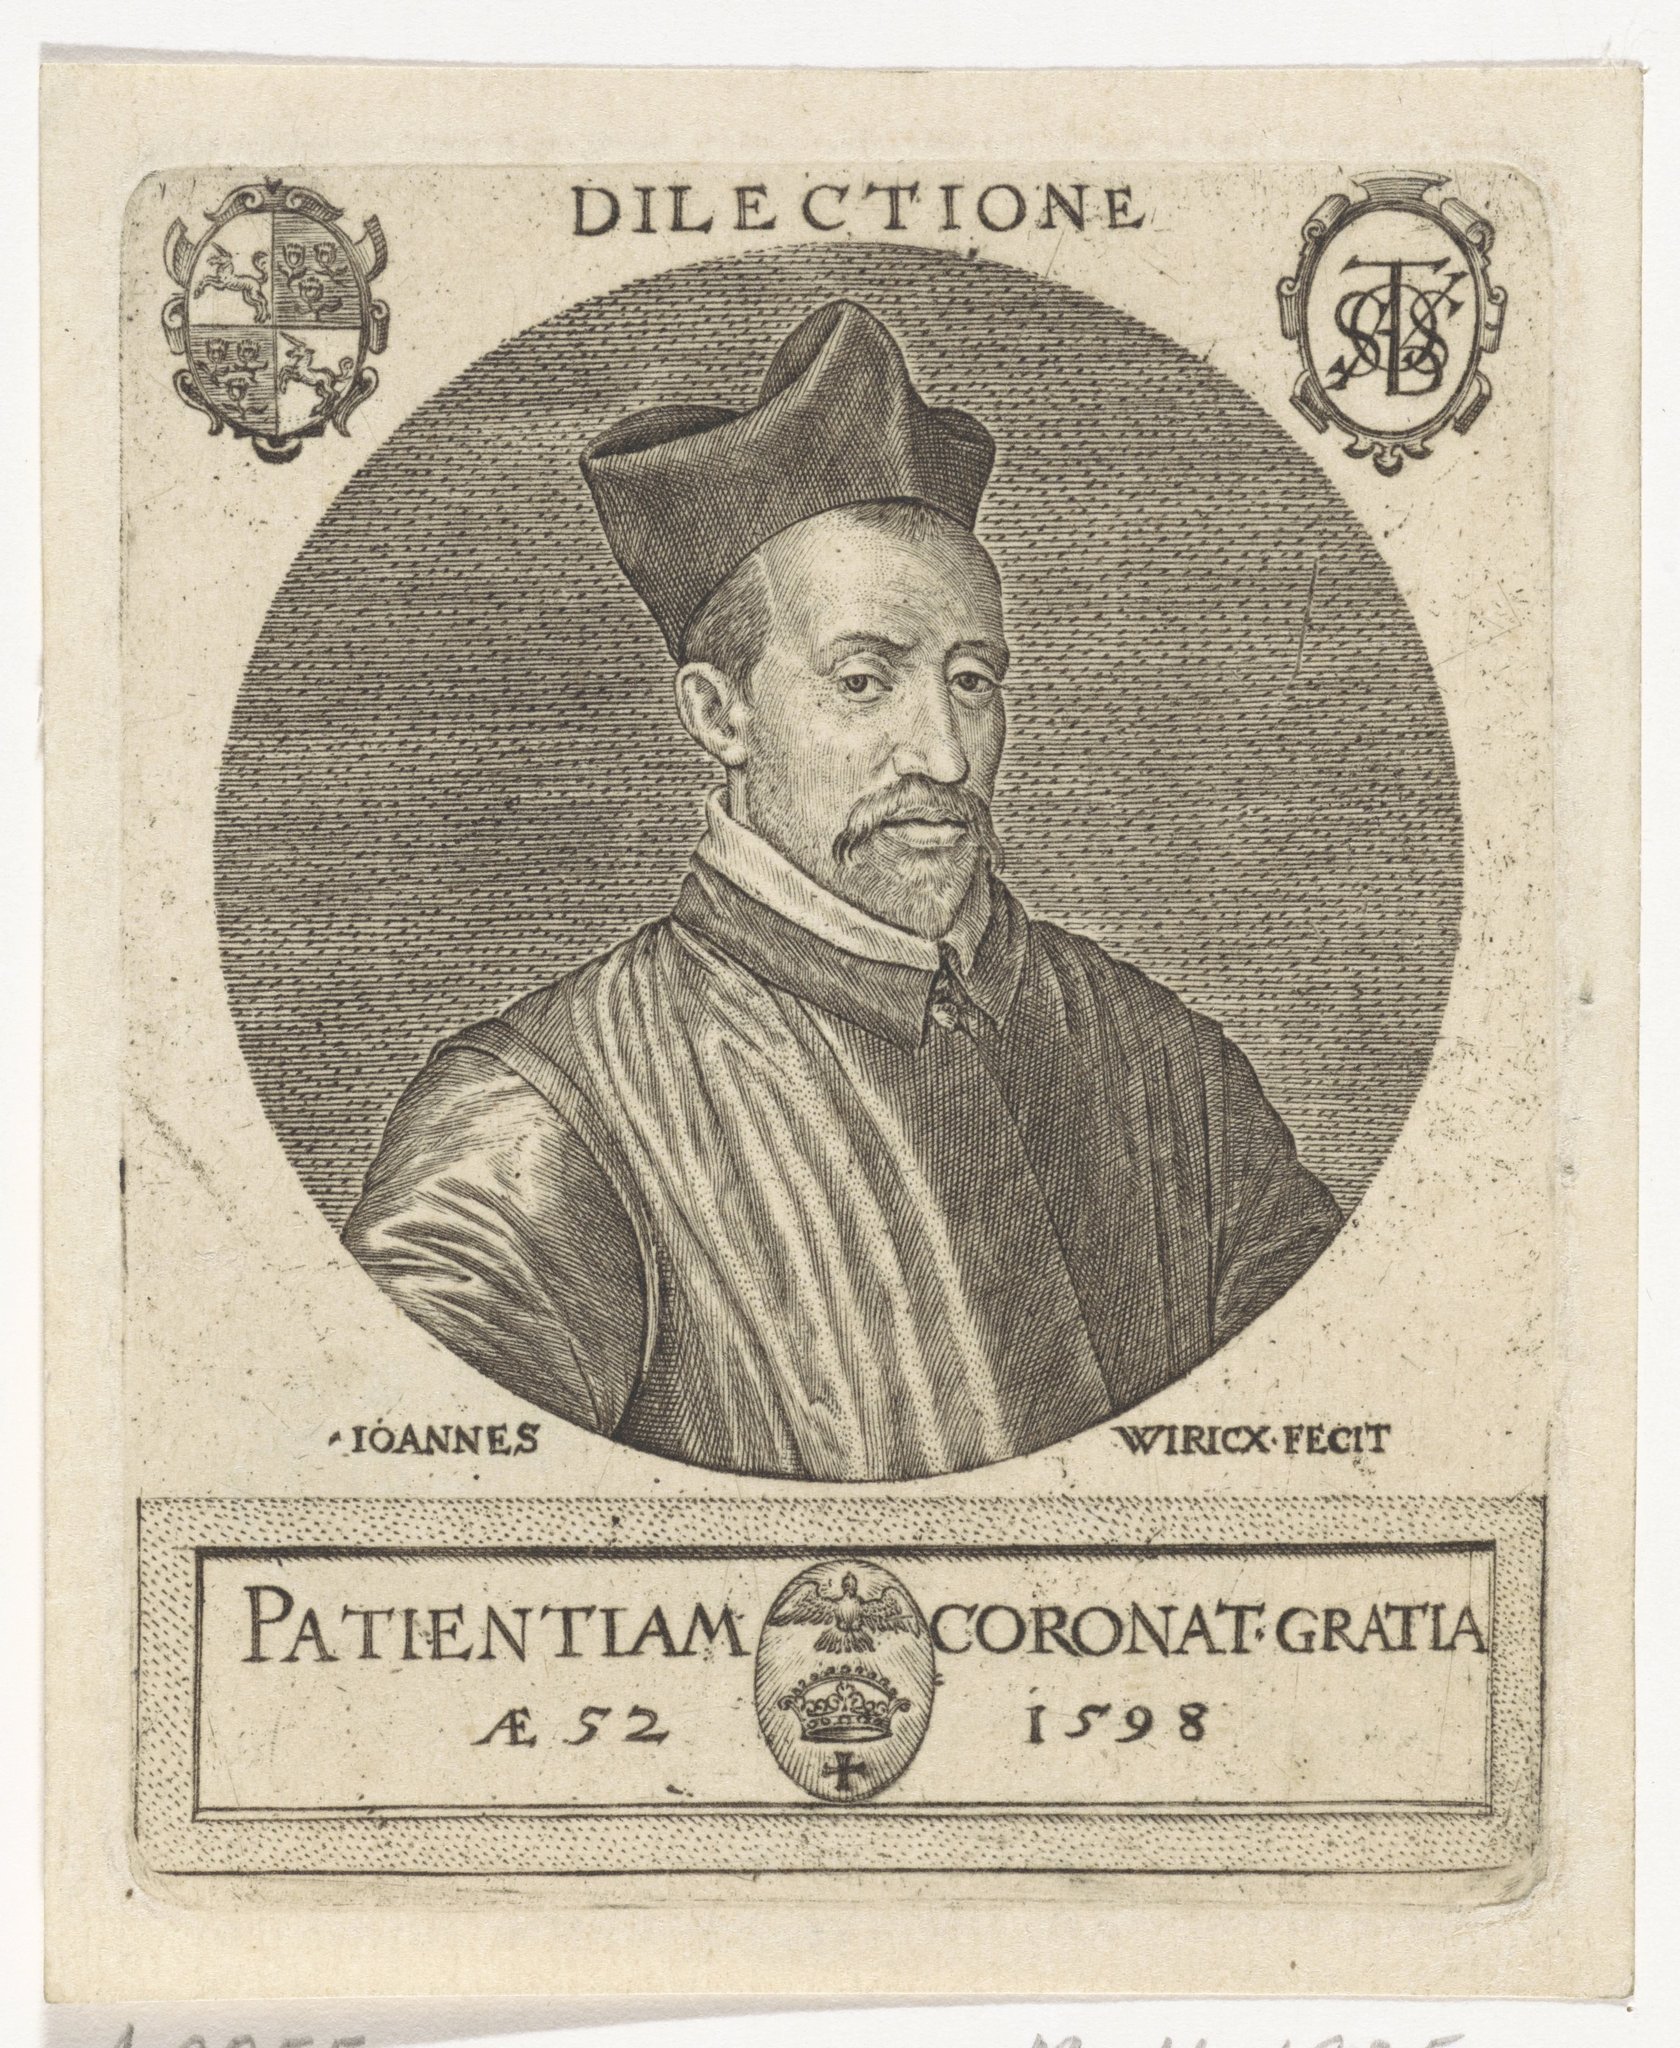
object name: print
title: Portret van Sasbout Vosmaer, op 52-jarige leeftijd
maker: johannes wierix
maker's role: draughtsman, print maker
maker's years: 1549-1618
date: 1598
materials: paper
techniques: engraving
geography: antwerp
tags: insignia of cardinal, e.g. hat, mantle, armorial bearing, heraldry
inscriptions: collector's mark: Lugt 2228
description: Portret van Sasbout Vosmaer. Hij draagt een biretta. Linksboven zijn wapenschild, rechtsboven zijn initialen. In het kader in de marge een motto in het Latijn.